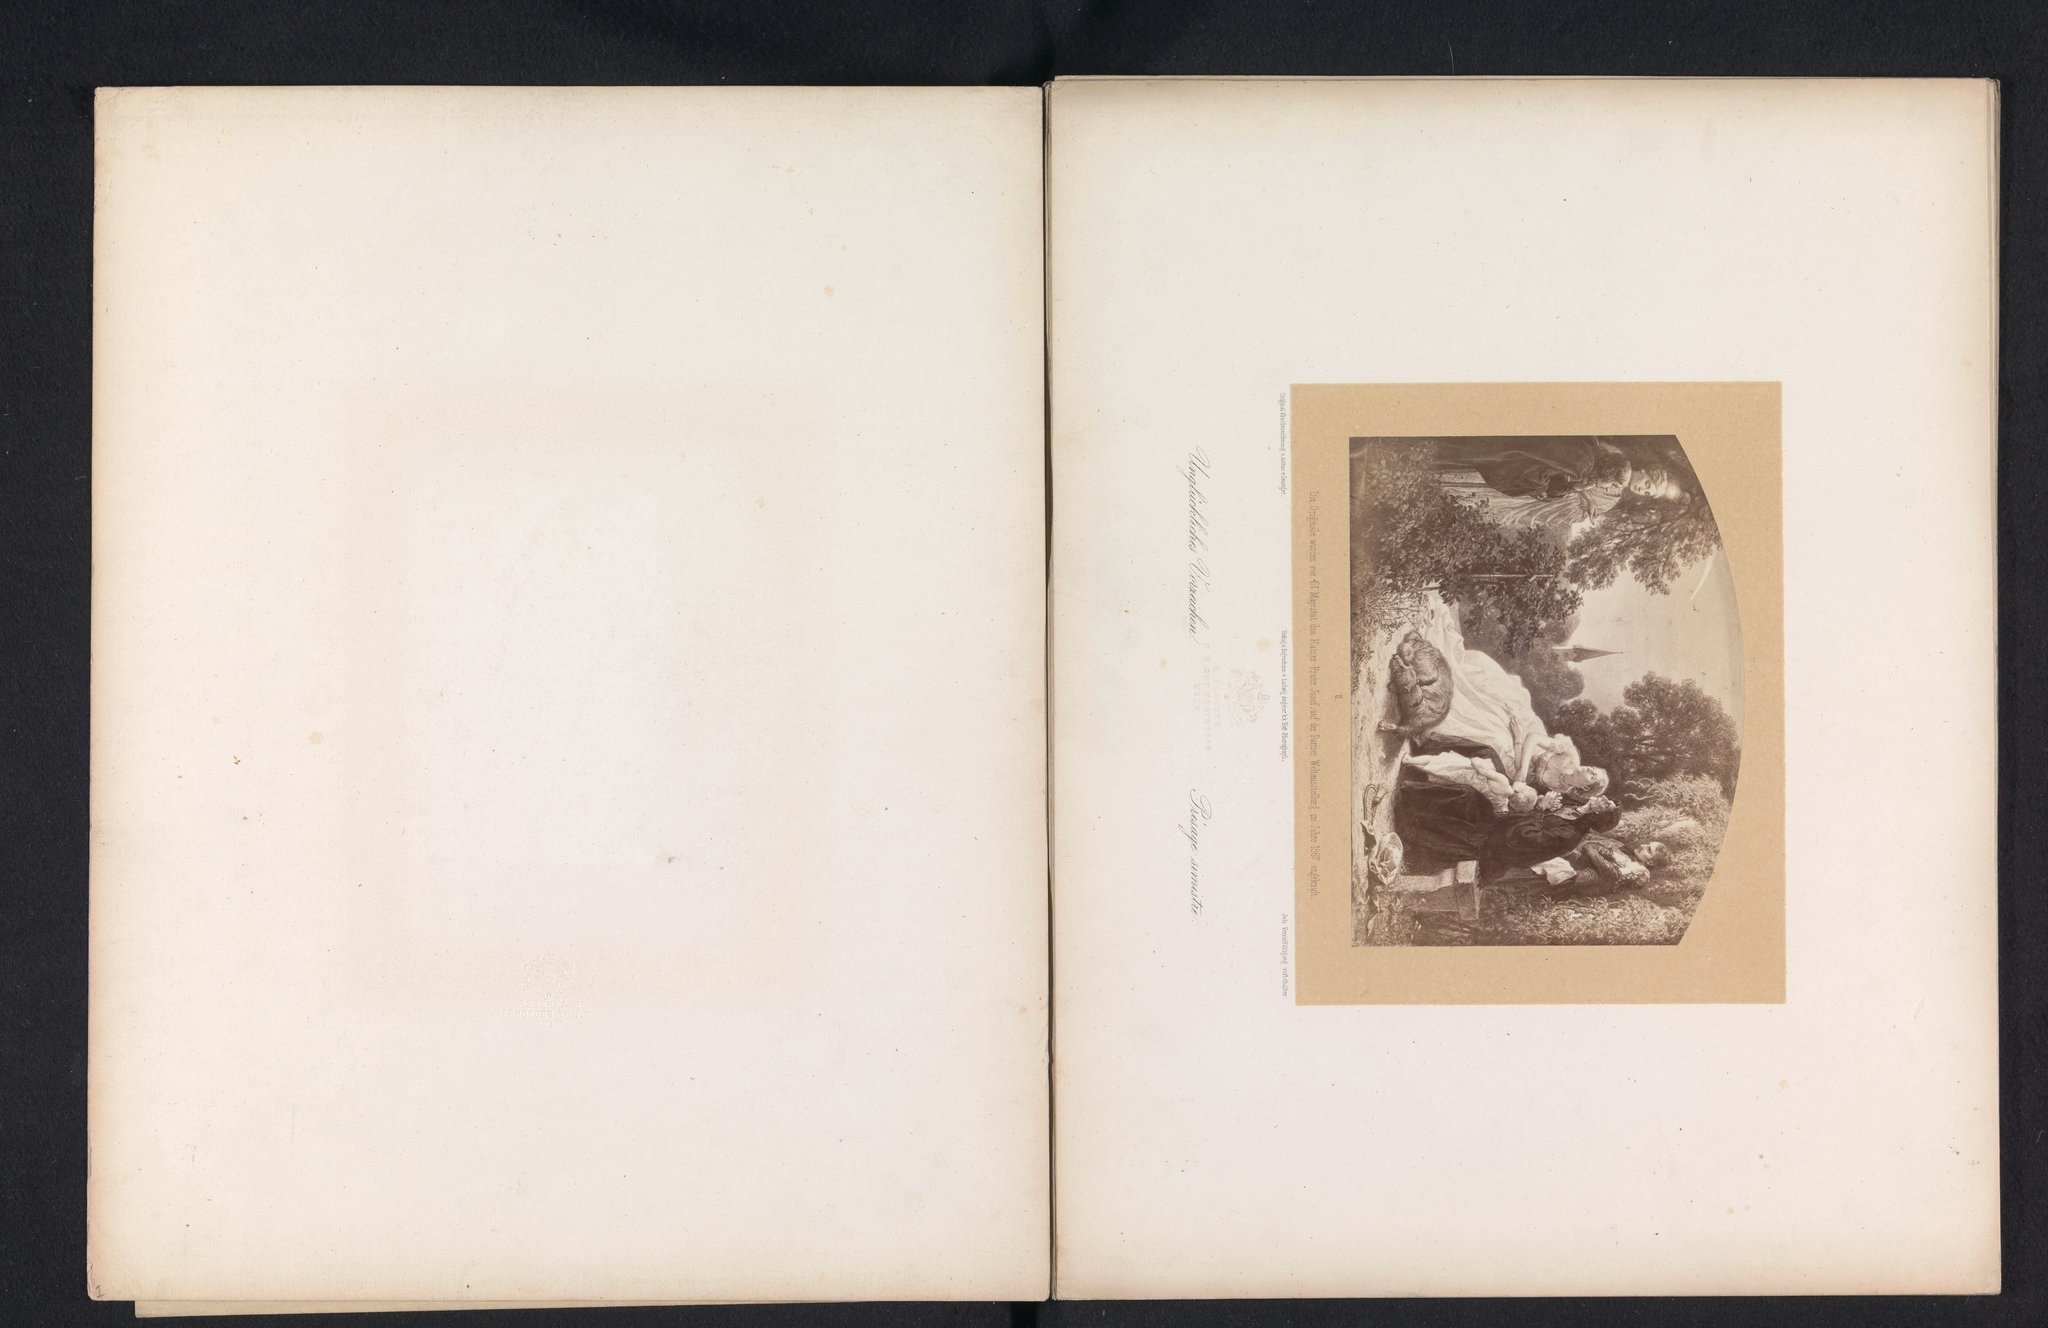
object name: page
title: Fotoreproductie van een tekening van een gezelschap in een tuin die kijken naar een streep licht aan de hemel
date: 1867-1868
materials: photographic support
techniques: albumen print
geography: vienna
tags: garden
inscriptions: inscription: ‘Die Originale wurden von Sr Majestat den Kaiser Franz Josef, auf der Pariser Weltausstellung im Jahre 1867 angekauft.’, number: ‘II.’